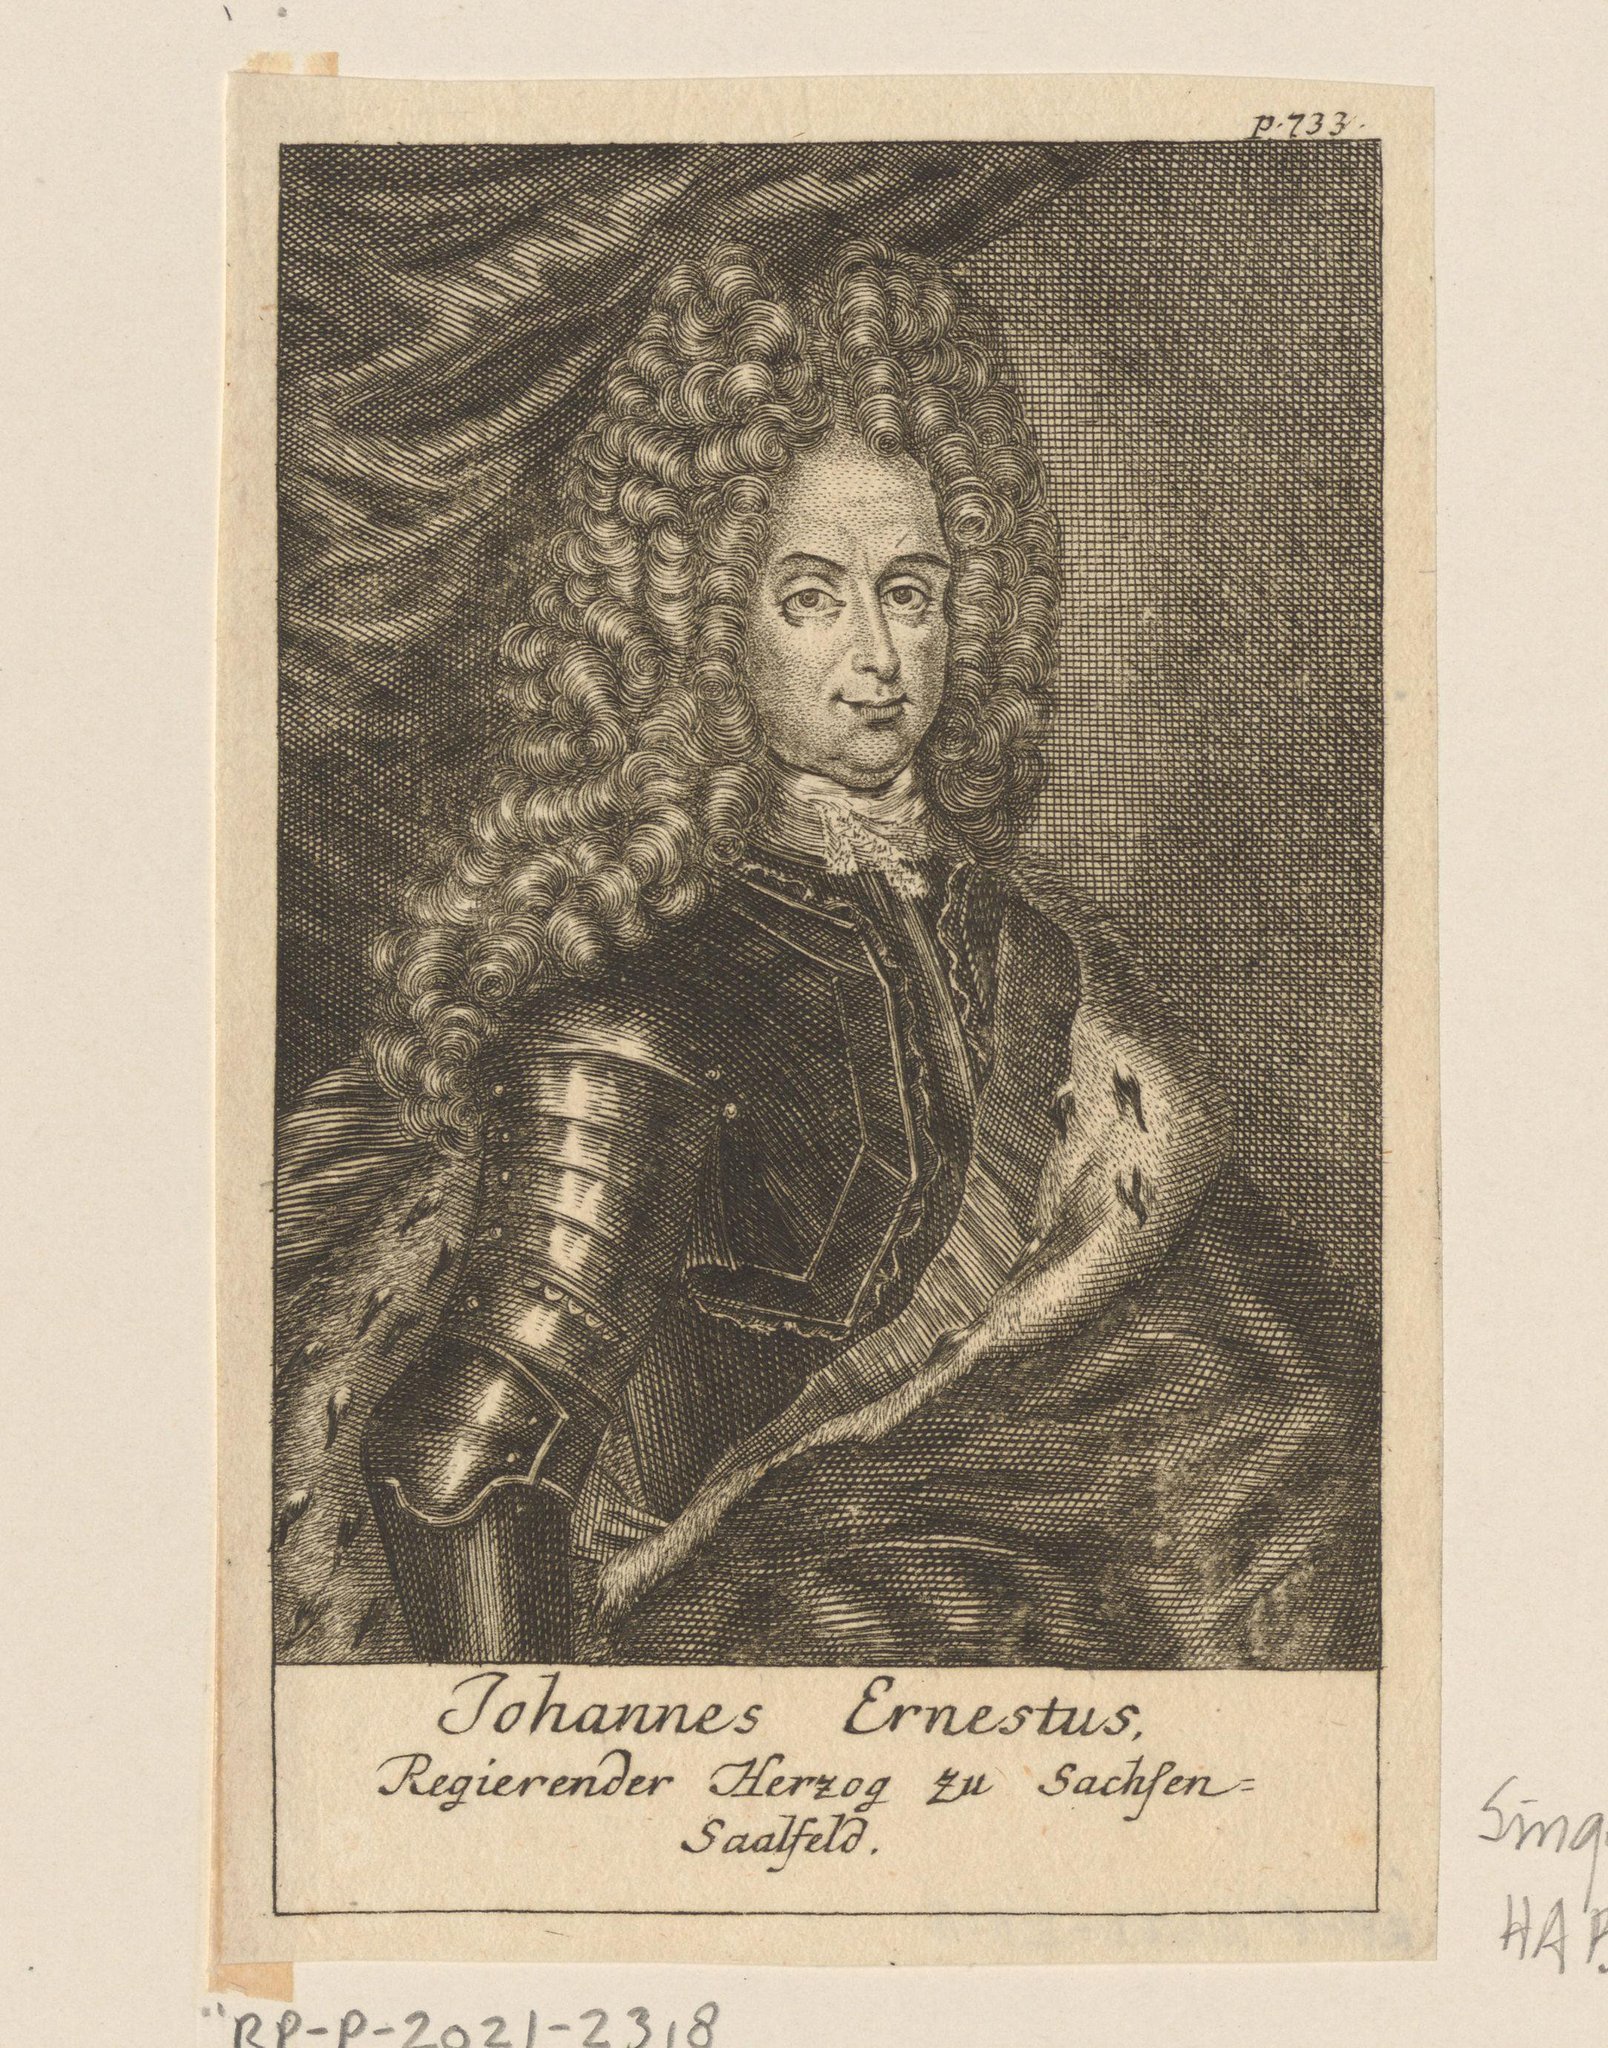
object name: print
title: Portret van Johann Ernst III, hertog van Sachsen-Coburg-Saalfeld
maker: Anonymous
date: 1680-1729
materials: paper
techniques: engraving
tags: historical persons, ruler, sovereign